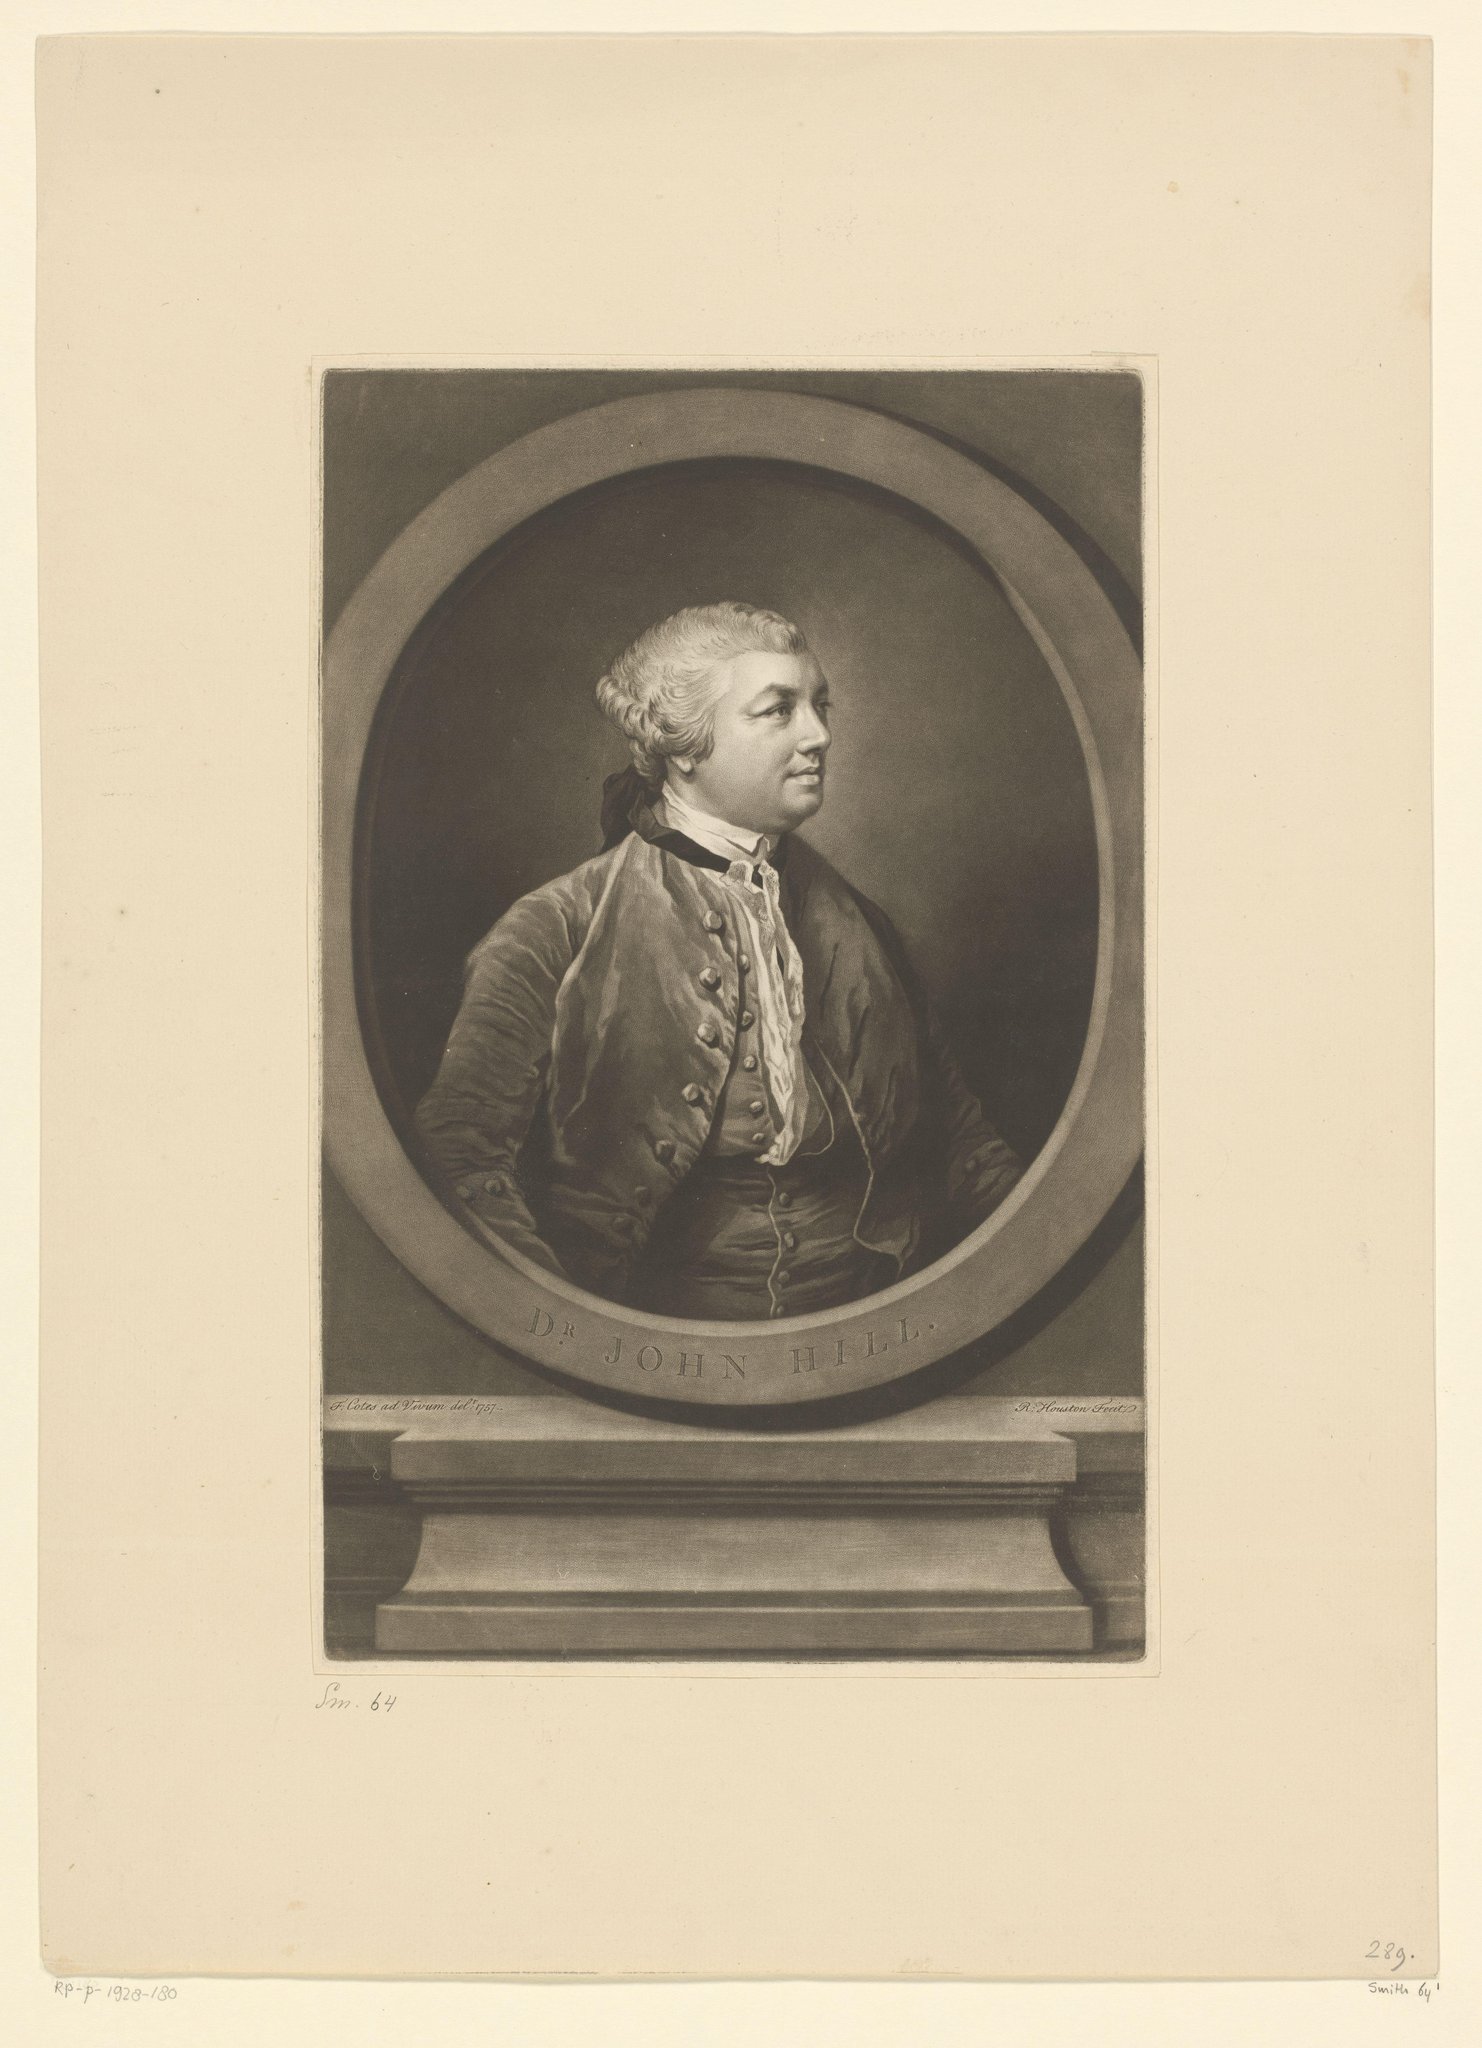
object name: print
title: Portret van John Hill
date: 1757-1775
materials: paper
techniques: etching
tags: london, botany (+ portrait of scholar, scientist), historical persons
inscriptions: collector's mark: Lugt 2228